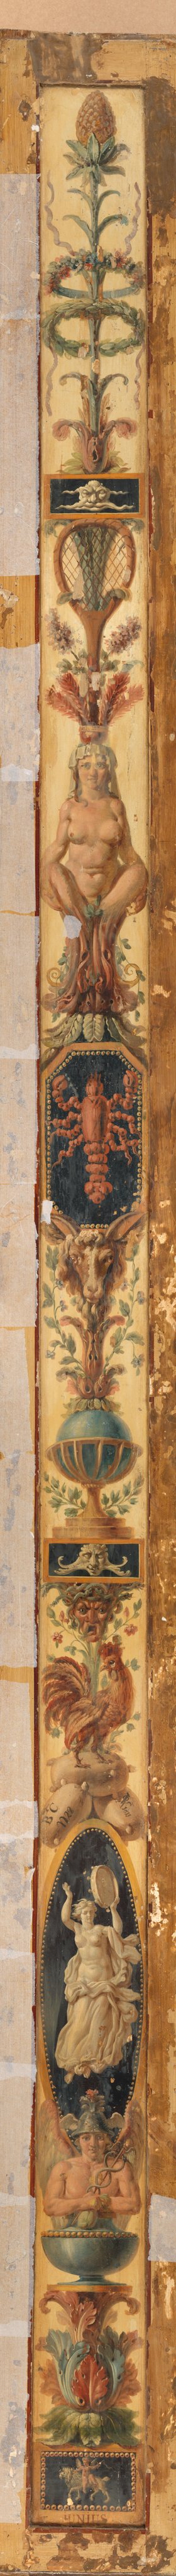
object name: painting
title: Nine Months with Signs of the Zodiac: June with the Sign of Cancer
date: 1791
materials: oil, panel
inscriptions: inscription, bottom centre: ‘Junius’ Junius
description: Zoals het opschrift onderaan vermeldt is het onderwerp van deze schildering de maand juni. Het teken van het sterrenbeeld Kreeft is afgebeeld op een reliëf met een zwart fond. Mercurius, beschermgod van juni, is te herkennen aan de Pegasus, cadaceus en beurs. De haan staat symbool voor zijn wakkerheid, de ram verwijst naar zijn rol als beschermer van herders en kudden en de racket met shuttle naar zijn beschermheerschap van de sport. De haan is overgenomen van de door Claude III Audran (1658-1734) omstreeks 1709 ontworpen tapijtenserie Le Douze Mois Grotesques, die door Jean Audran (1667-1756) in prent is gebracht. Op de prent met de maanden mei en juni zijn bij mei behalve een haan tevens een ram, handelswaar en rackets te zien, waarvan Maderna een eigen interpretatie heeft geschilderd. Een tweede inspiratiebron was Le antichità di Ercolano esposte (Napels 1757-1792). De vrouw met de tamboerijn is hieruit in detail gekopieerd (dl. 1 (1757), p. 109). Dit is de enige schildering uit de serie die verwijst naar Josephus Augustus Brentano (1753-1821), de opdrachtgever. De letters B.C. op een van de zakken staan voor het koopmanshuis Brentano & Comp. Ook de poedel, bereden door een putto, heeft een persoonlijke betekenis. Dat Brentano op zijn poedel was gesteld blijkt uit Maderna’s levensgrote portret van hem en zijn huisdier, het schouwstuk in de grote zaal, waar de hier besproken pilasterpanelen de wanden sierden (Stichting Brentano’s Steun des Ouderdoms, Amstelveen). Deze schildering maakt deel uit van een serie pilasterpanelen (SK-A-4142 t/m SK-A-4150), gemaakt in opdracht van Josephus Augustus Brentano (1753-1821) voor zijn huis Herengracht 544.